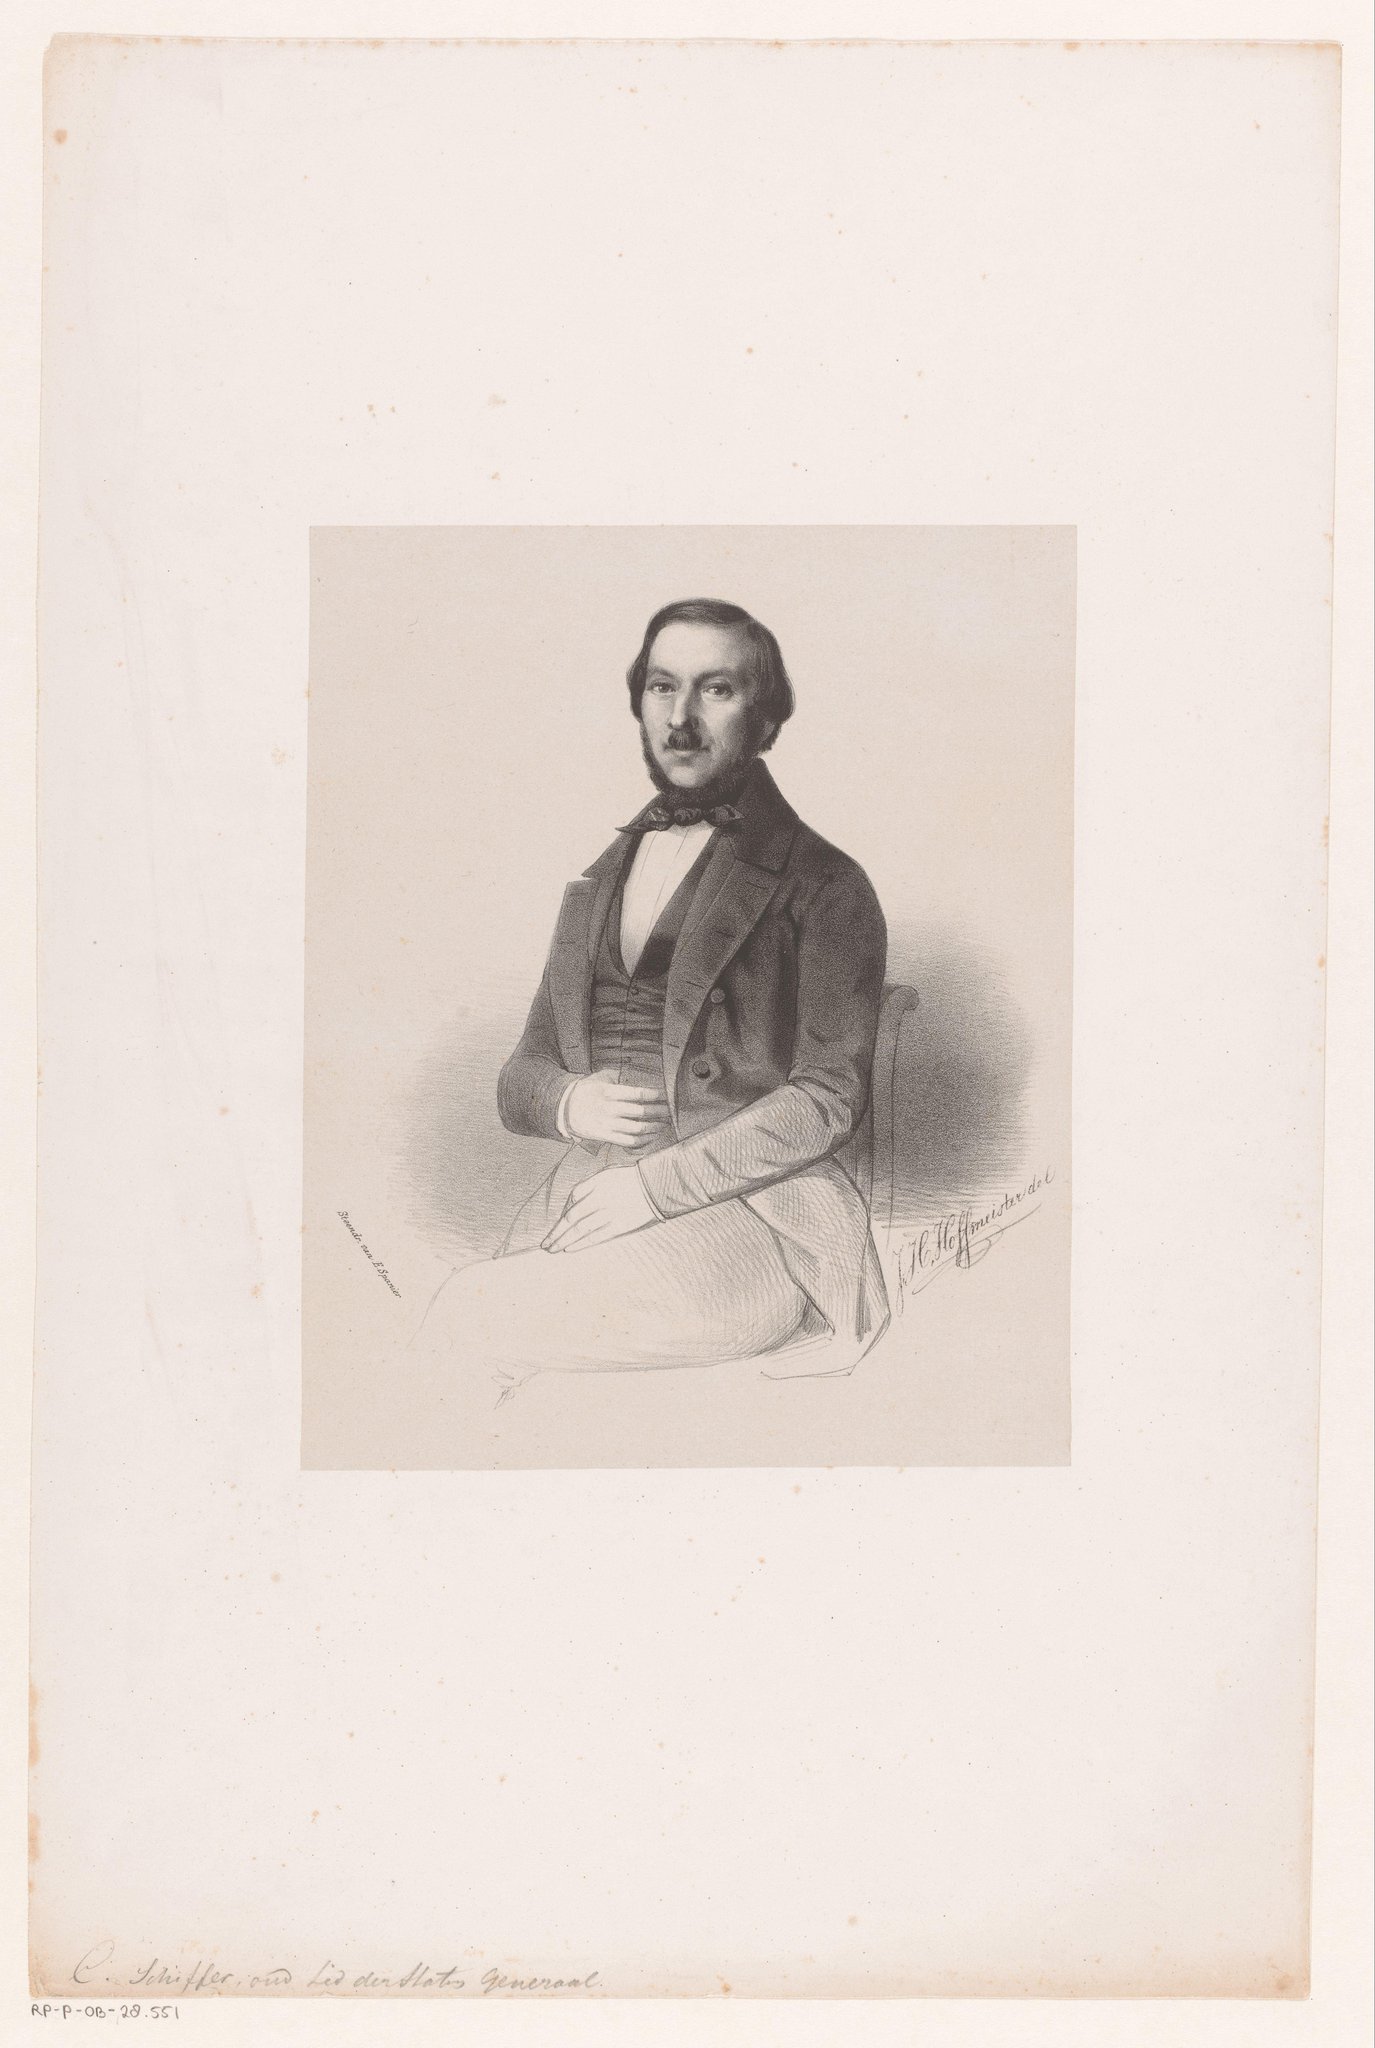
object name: print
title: Portret van Cornelis Schiffer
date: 1843-1863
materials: paper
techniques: lithograph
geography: netherlands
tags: historical persons (+ three-quarter length portrait)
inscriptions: collector's mark: Lugt 2228